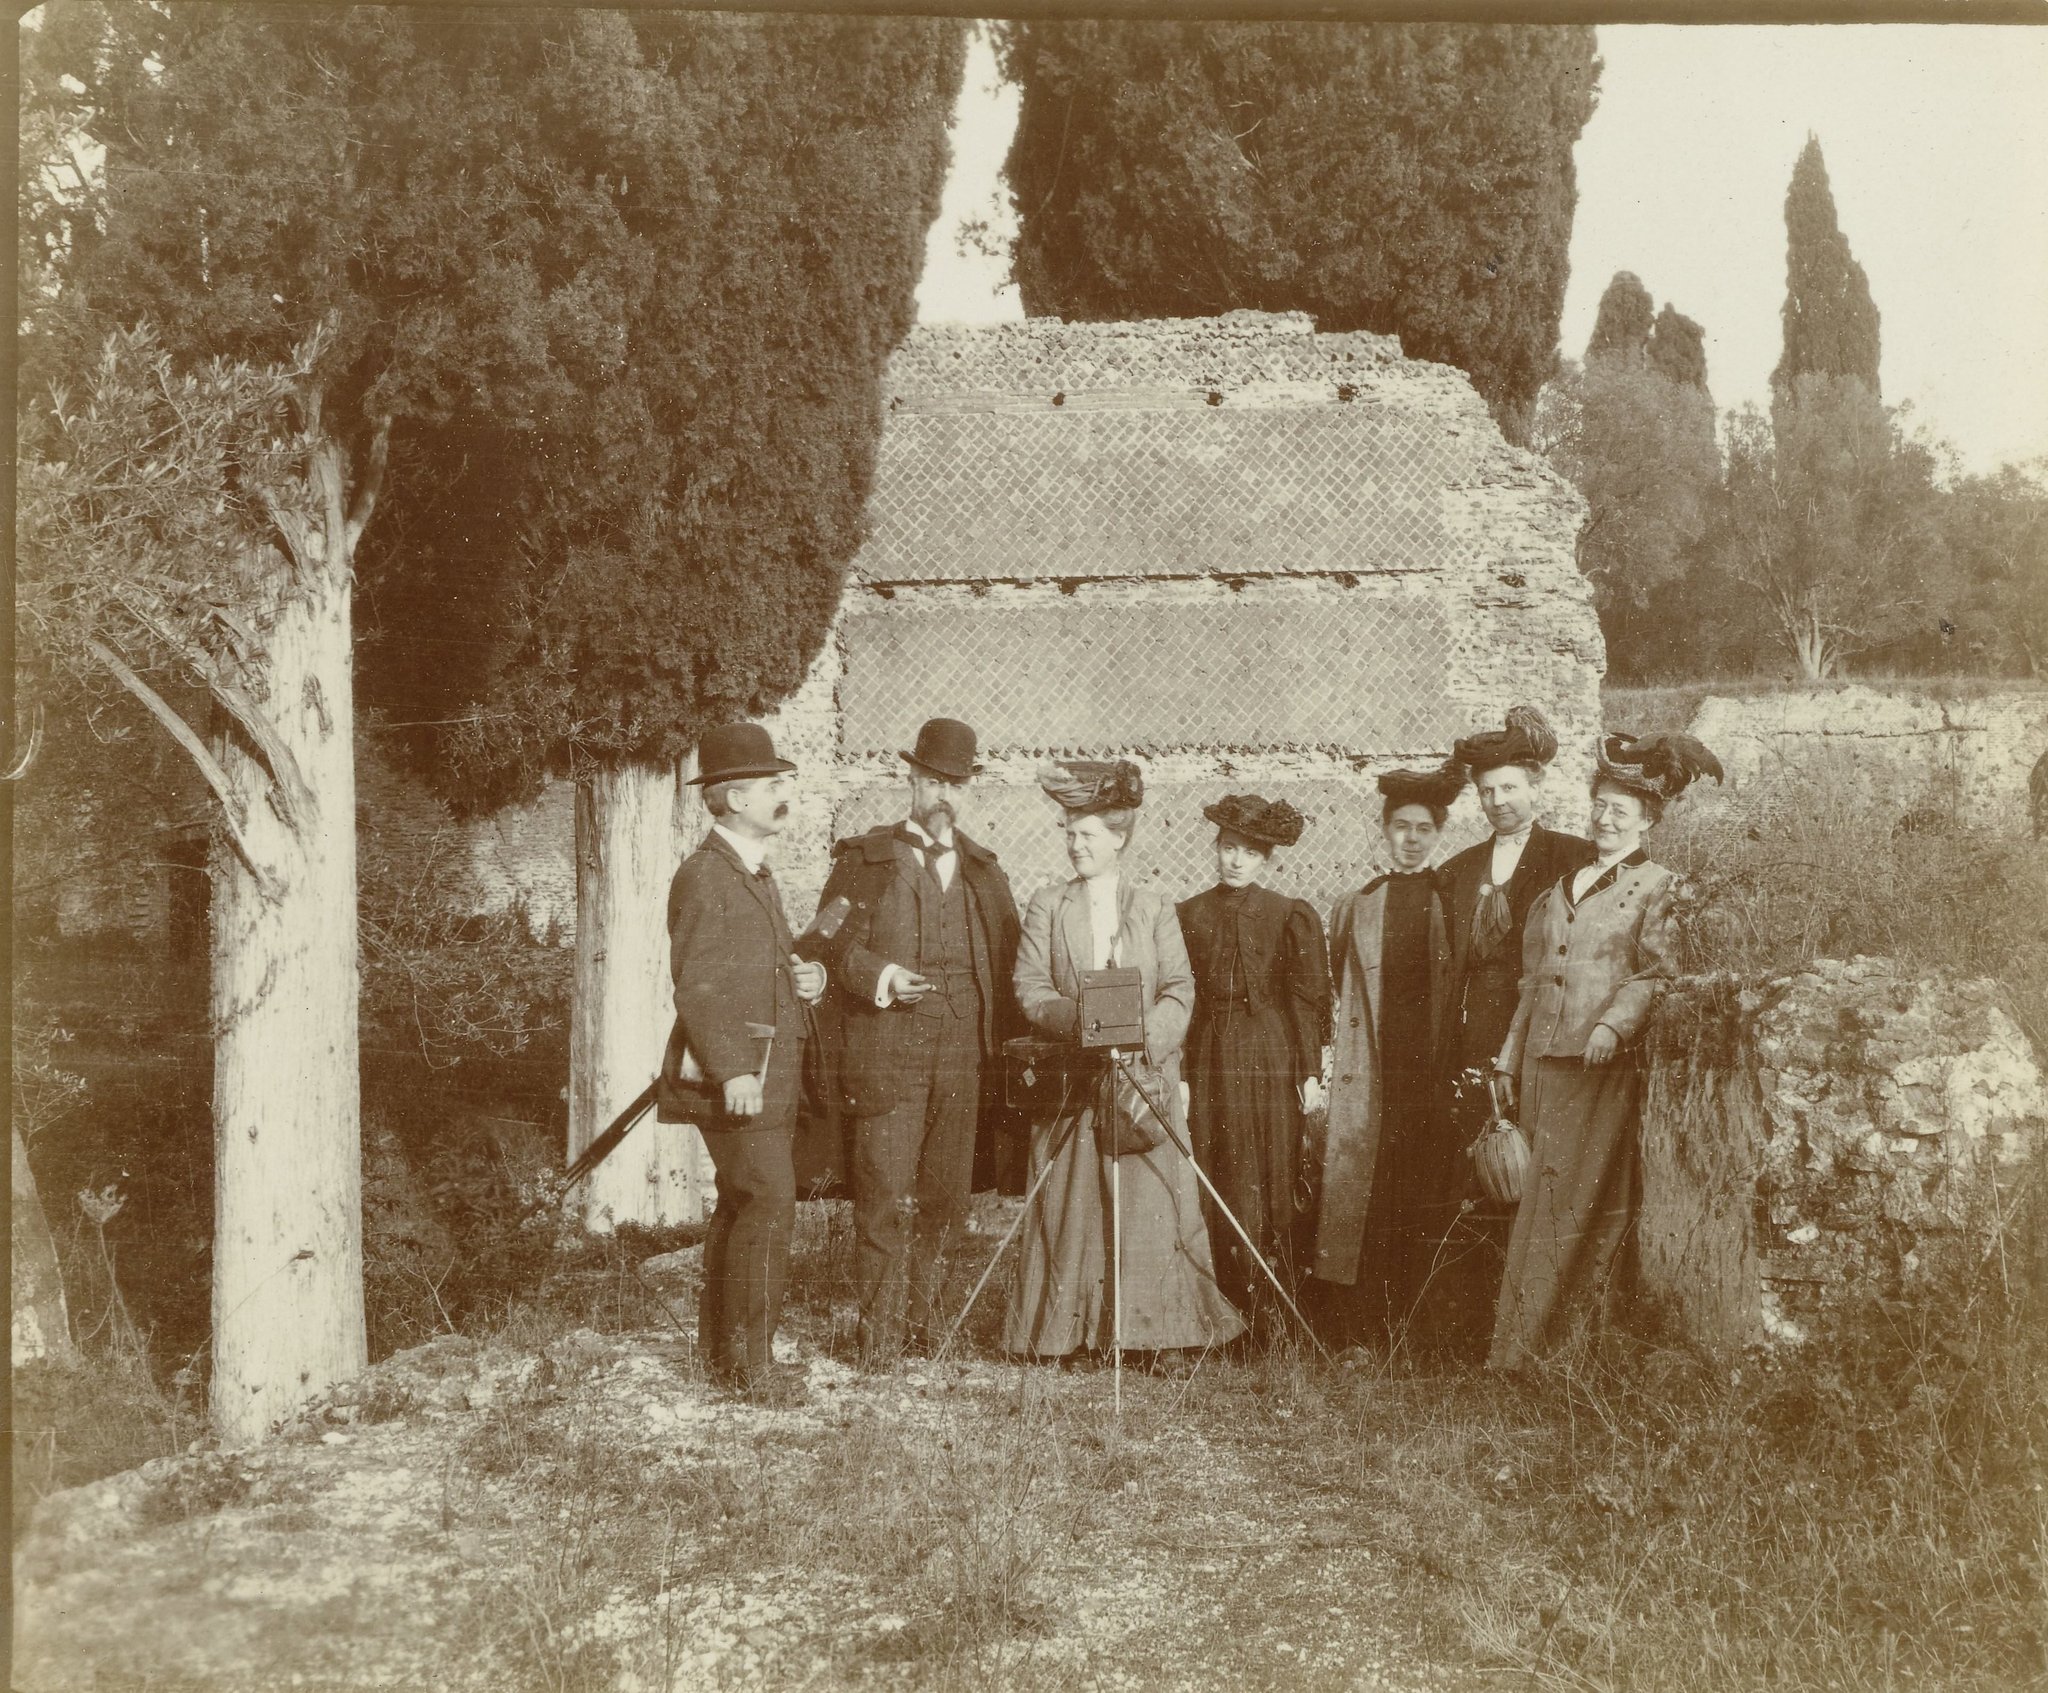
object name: photograph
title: Groepsportret van vijf onbekende vrouwen (van wie één achter een camera) en twee mannen voor een ruïne in Italië of Frankrijk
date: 1885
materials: paper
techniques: gelatin silver print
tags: camera ~ photography, landscape with ruins, anonymous historical persons portrayed in a group, in a group-portrait, italy, france